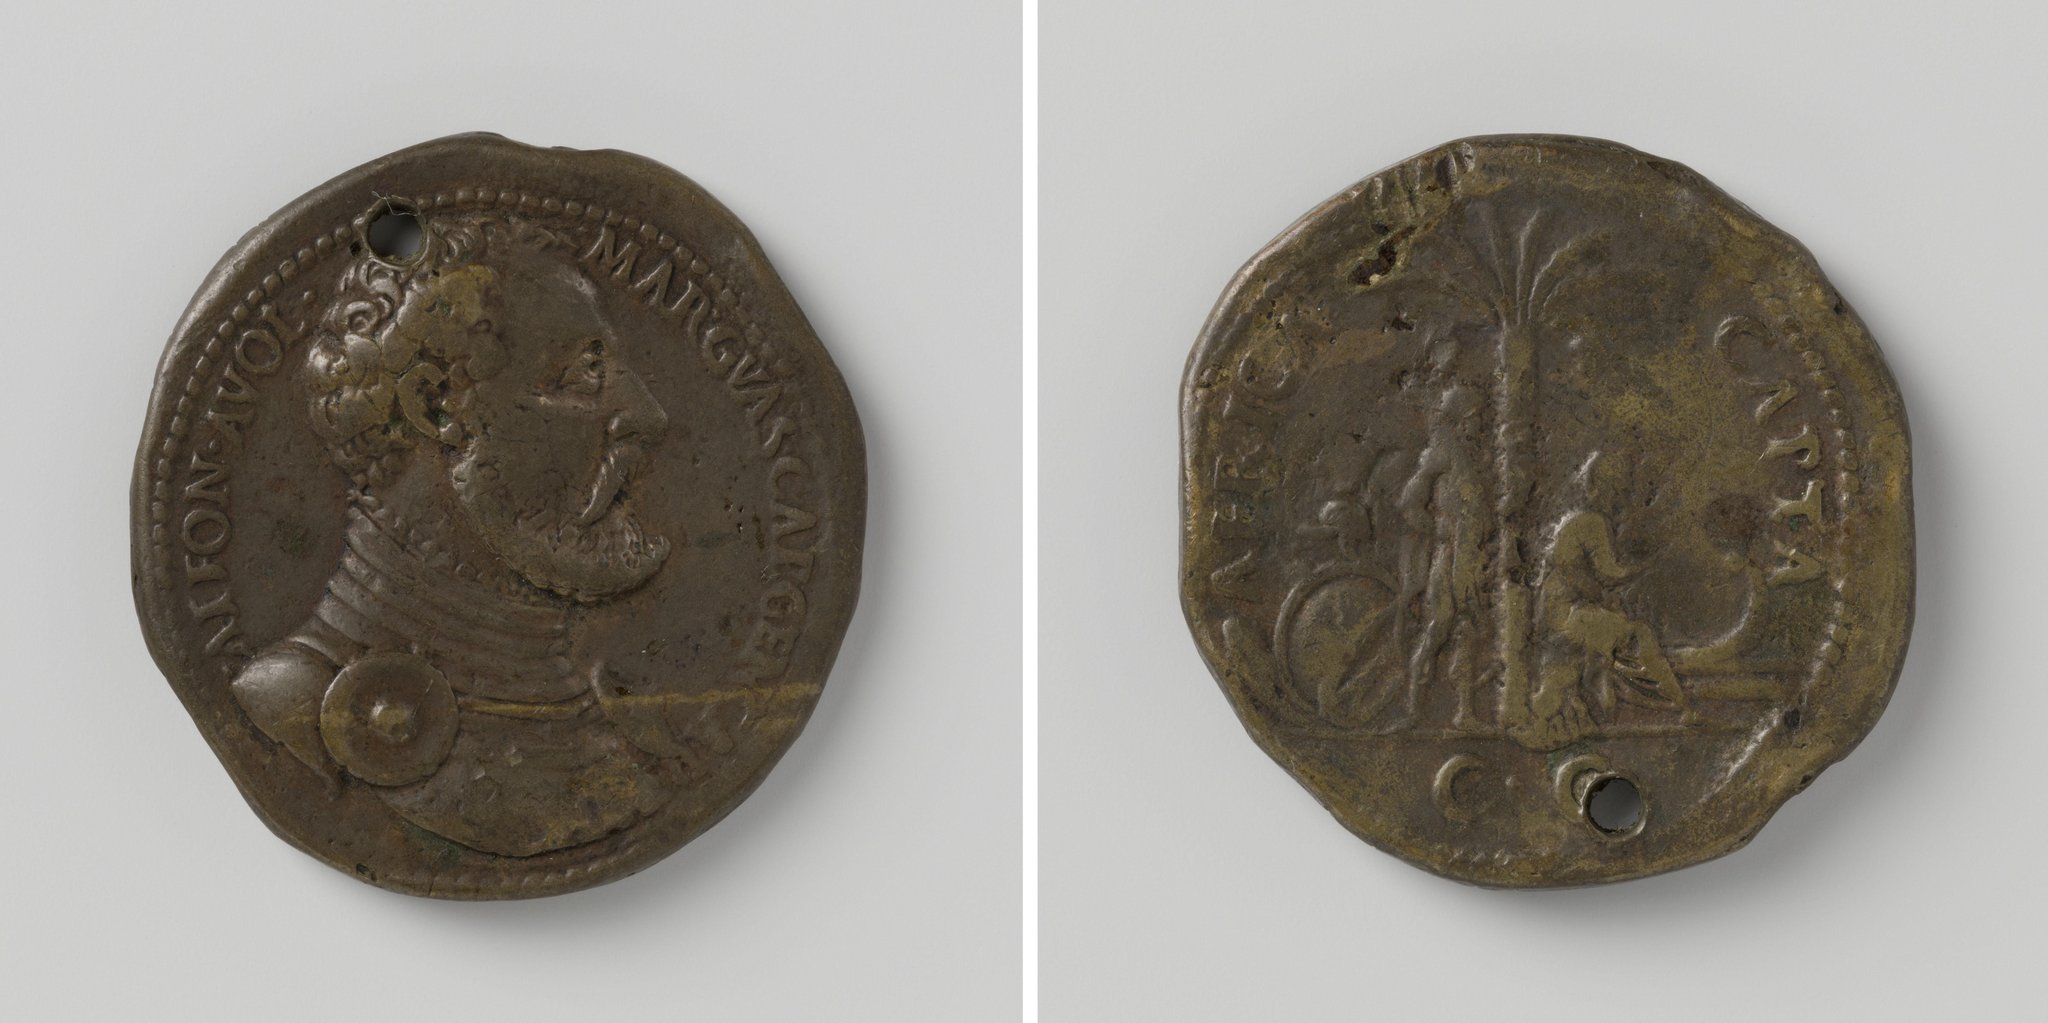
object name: history medal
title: Alfonso d'Avalos, markies van Vasto, veldheer van Karel V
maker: giovanni cavino (copie naar)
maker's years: 1500-1571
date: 1535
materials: bronze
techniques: casting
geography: italy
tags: ghent, charles v (holy roman emperor and king of spain), ischia, isola d'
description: Bronzen penning met gat erin. Voorzijde: borststuk man binnen omschrift. Keerzijde: Afrika, afgebeeld als zittende vrouw onder palmboom en Alfonso tussen wapentuig en schip binnen omschrift; afsnede: opschrift